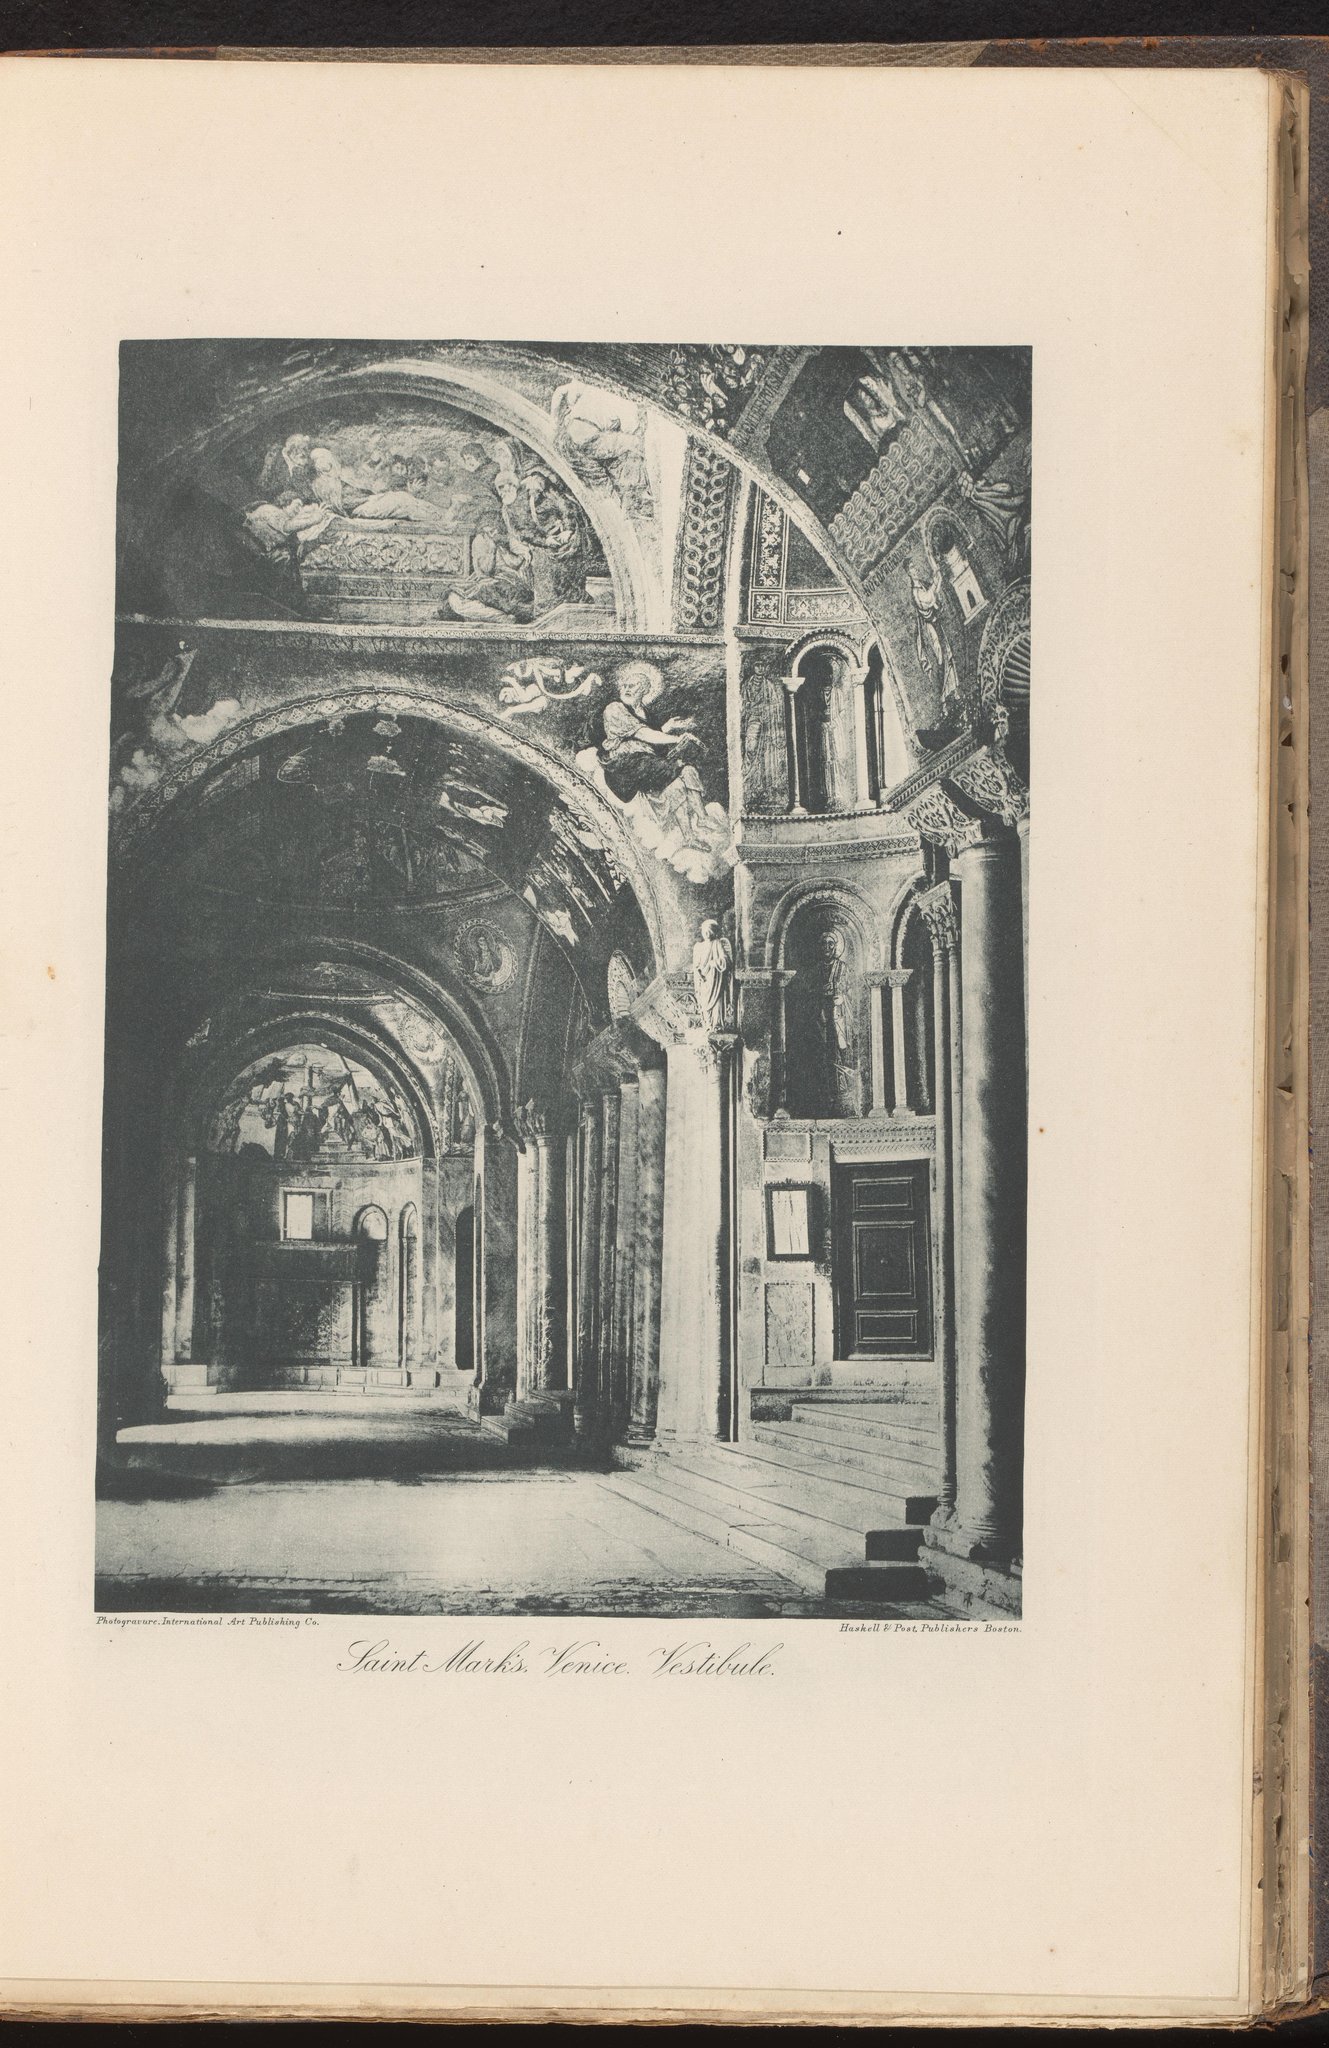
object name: page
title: Saint Marks, Venice. Vestibule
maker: Anonymous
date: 1881-1886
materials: paper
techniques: photograph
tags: interior of church